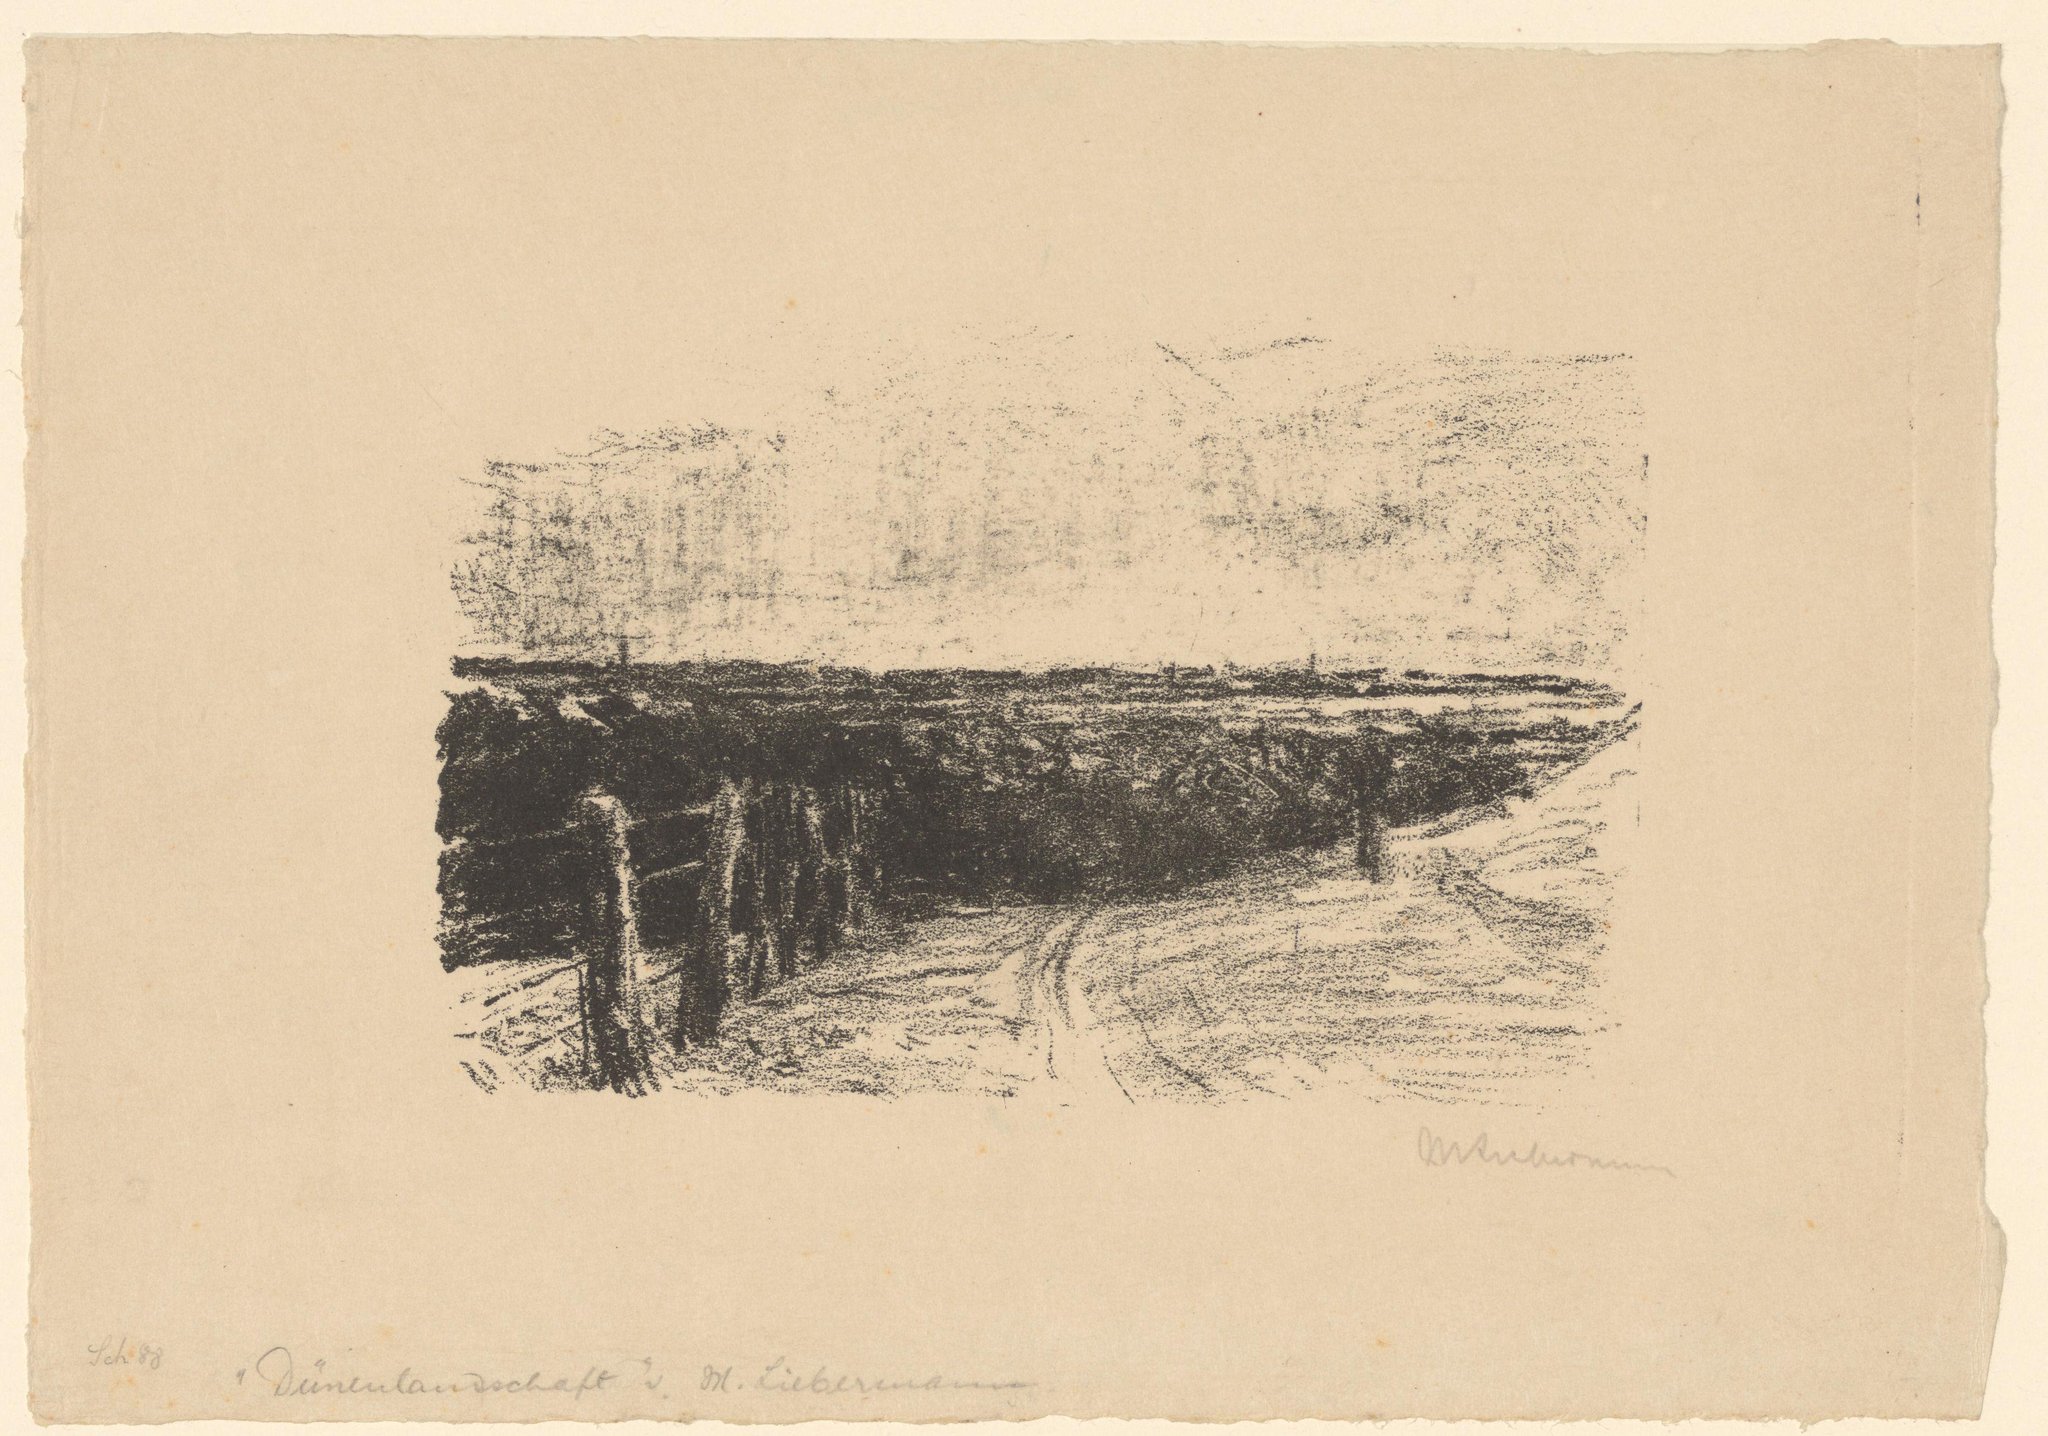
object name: print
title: Dünenlandschaft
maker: max liebermann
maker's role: draughtsman, print maker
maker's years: 1847-1935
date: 1857-1923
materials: paper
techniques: lithograph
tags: dunes (sea not visible); in the dunes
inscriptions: : ‘Printed in Germany’, collector's mark: Lugt 2228